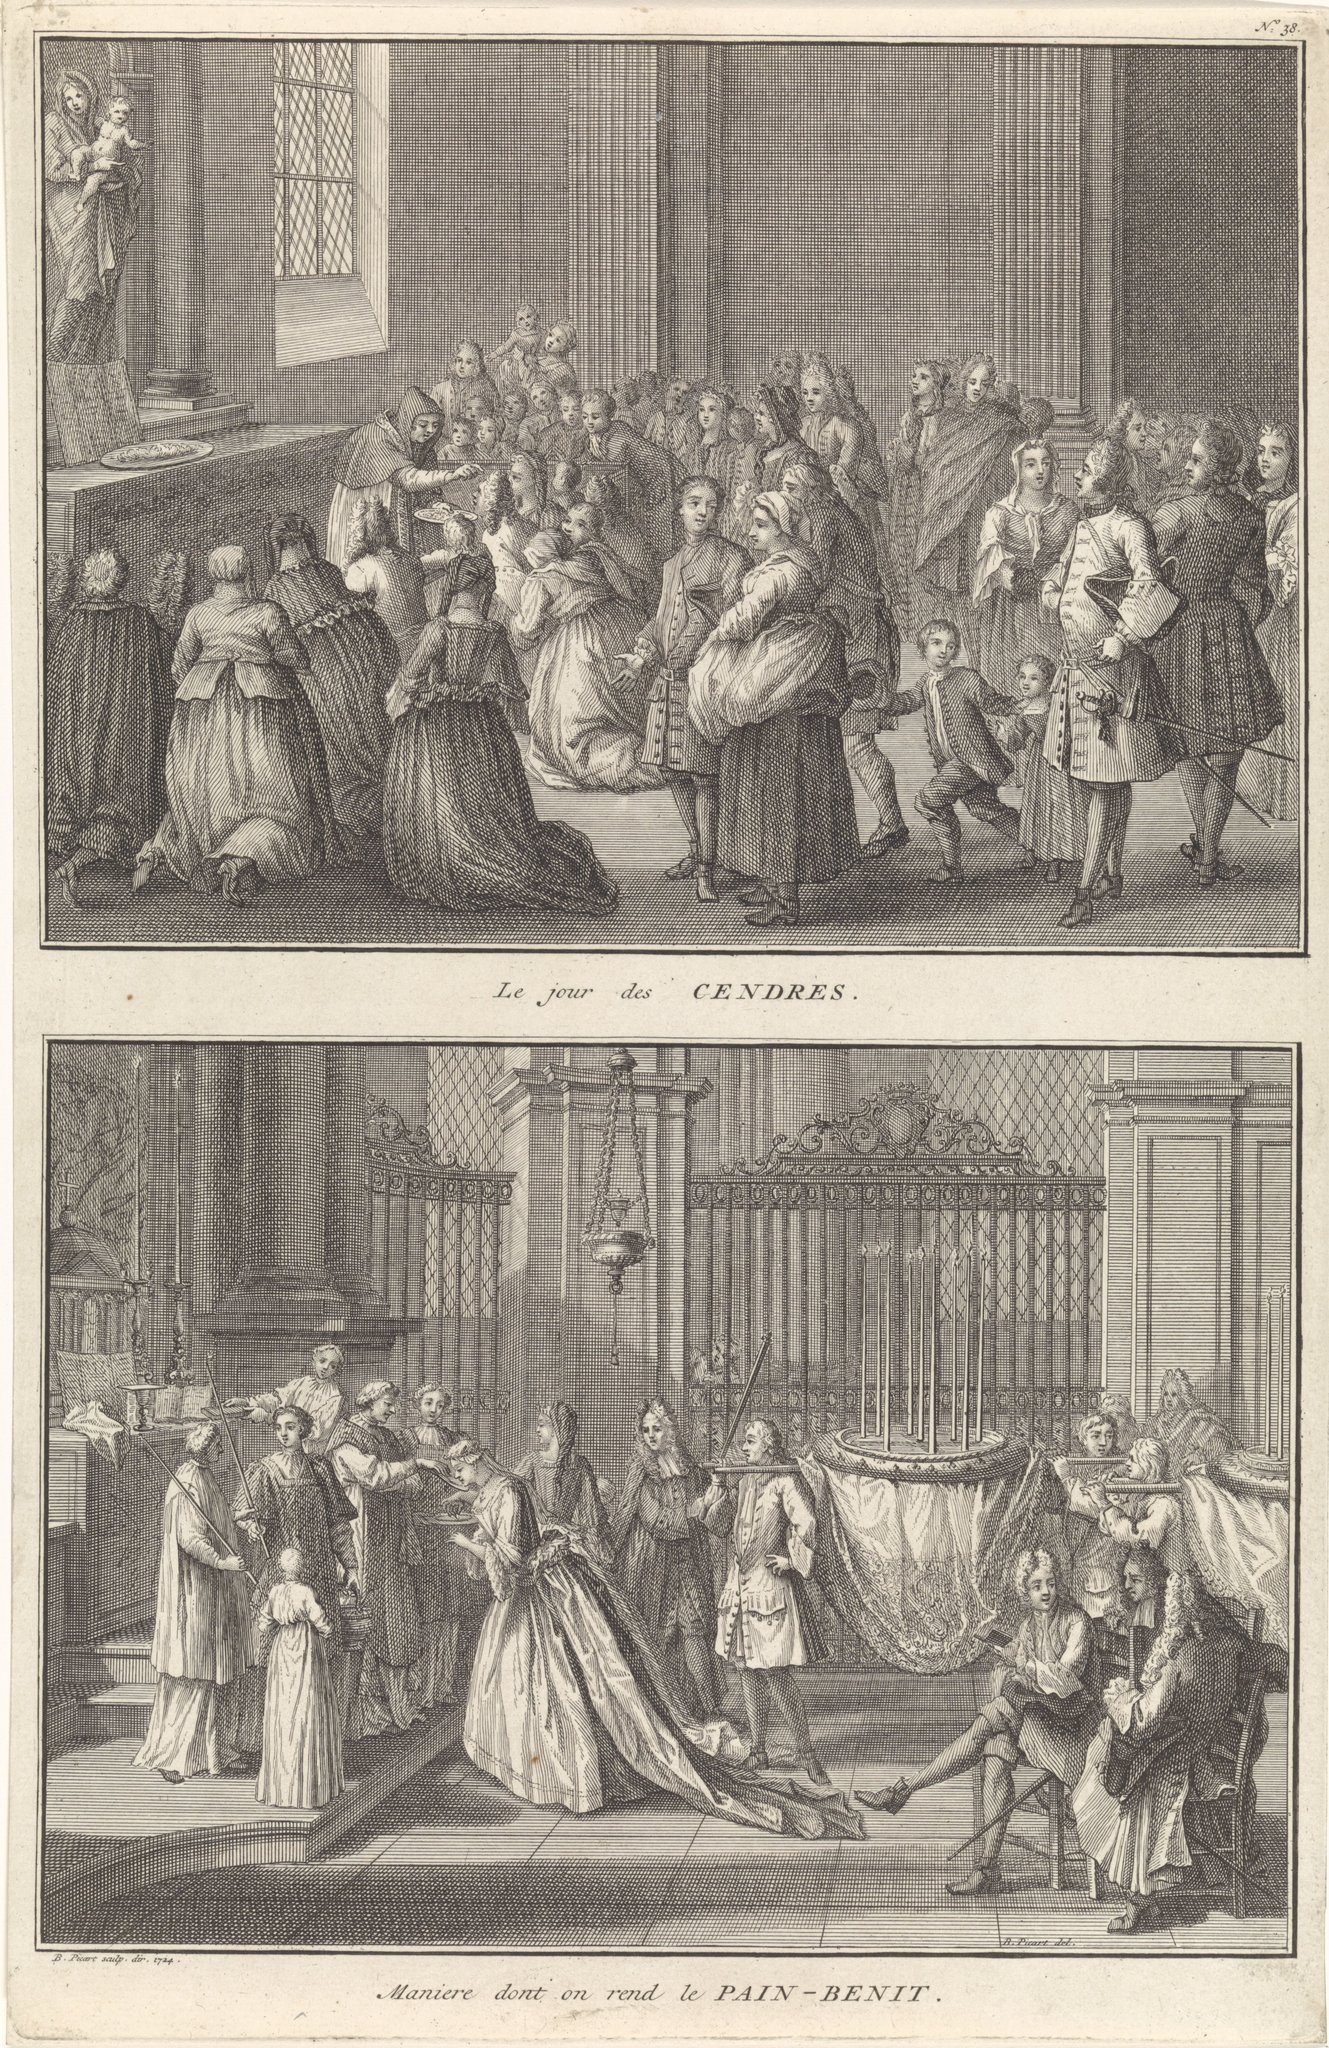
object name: print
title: Le jour des Cendres (...)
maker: bernard picart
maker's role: draughtsman, print maker, publisher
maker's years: 1673-1733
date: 1724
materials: paper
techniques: engraving, etching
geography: amsterdam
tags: ash wednesday, communion ~ holy mass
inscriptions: collector's mark: Lugt 2233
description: Blad met twee voorstellingen van bijeenkomsten in de rooms-katholieke kerk. Boven: Op de vastendag van Aswoensdag ontvangen de gelovigen een askruisje op het voorhoofd. Onder: Een vrouw ontvangt de gewijde hostie tijdens de viering van de Eucharistie. Achter haar dragen mannen brandende kaarsen. Rechtsboven genummerd: No. 38.